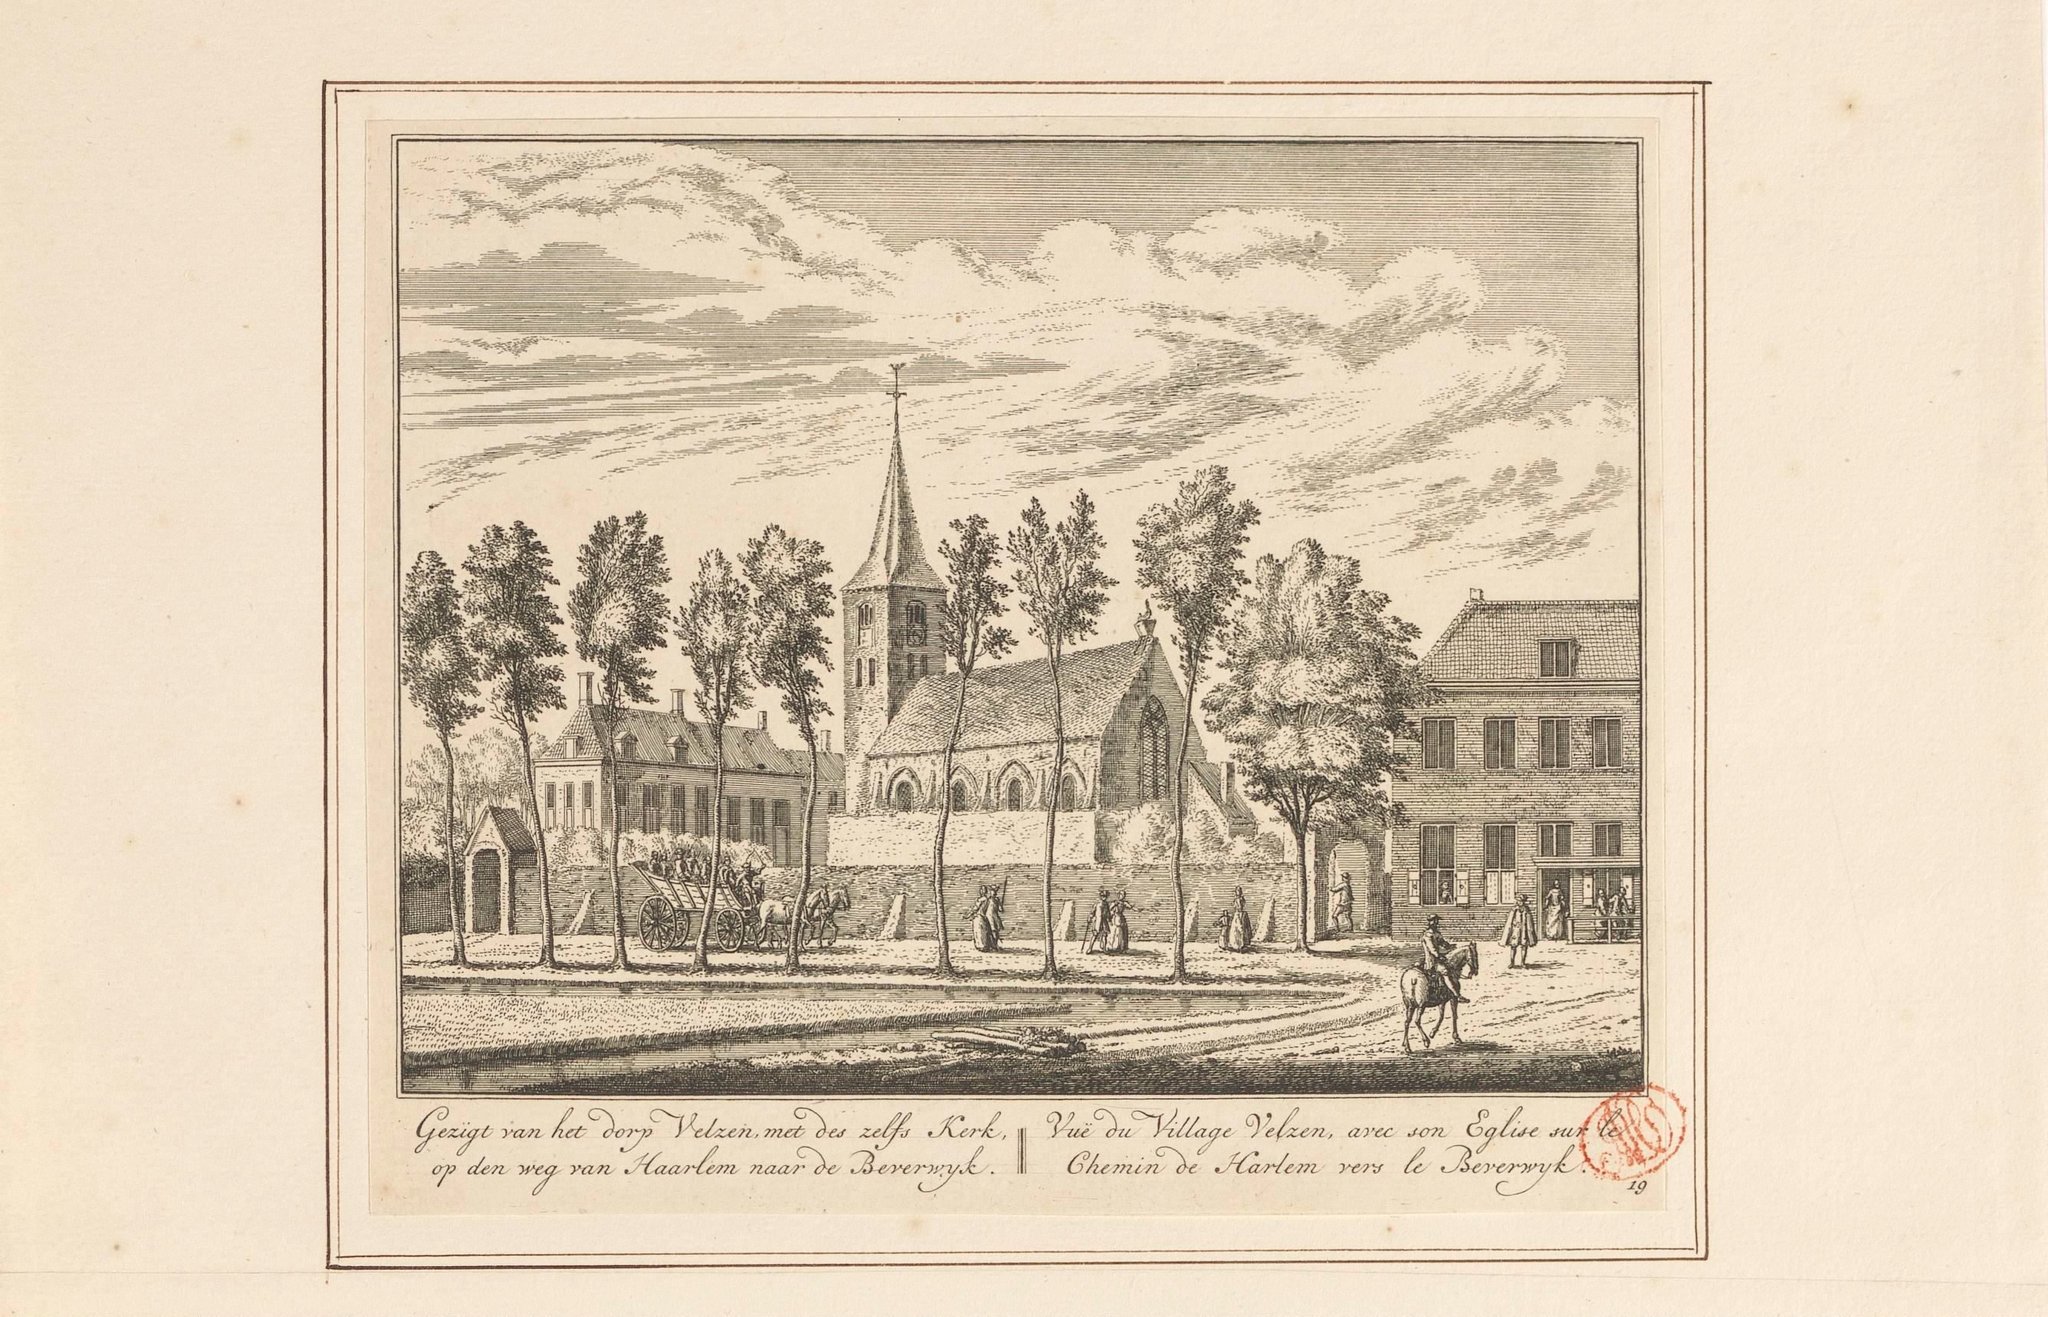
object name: book illustration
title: Gezicht op Velsen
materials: paper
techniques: etching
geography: amsterdam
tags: prospect of village, silhouette of village, church (exterior), public road in village (+ city(-scape) with figures, staffage)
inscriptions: collector's mark: Lugt 195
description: Prent ook gebruikt in: Rademaker, Abraham. Hollands Tempe verherelykt, vertoond in dertig uitmuntende gezigten; beginnende van Amsterdam (…) / La Hollande et tout son eclat et beauté, remontrée par trente exellentes vues, commençant d'Amsterdam (…). Amsterdam: Leonard Schenk, 1728.